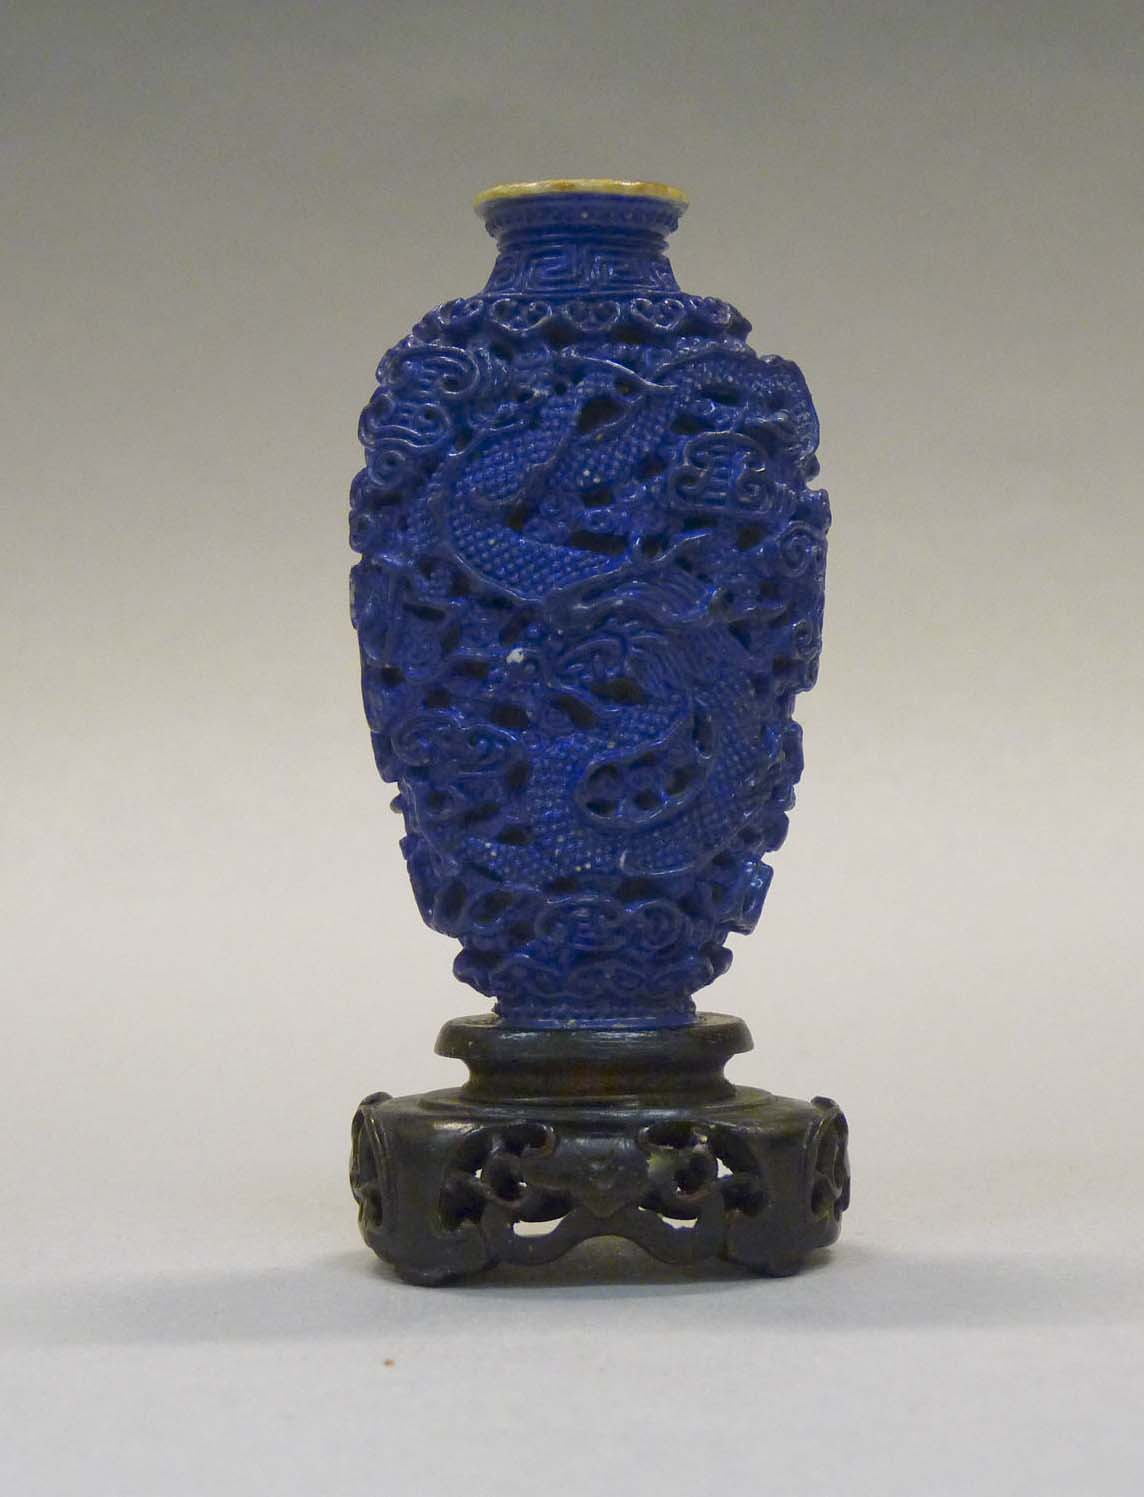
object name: snuff bottle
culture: chinese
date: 1736-1795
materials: porcelain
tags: dragons